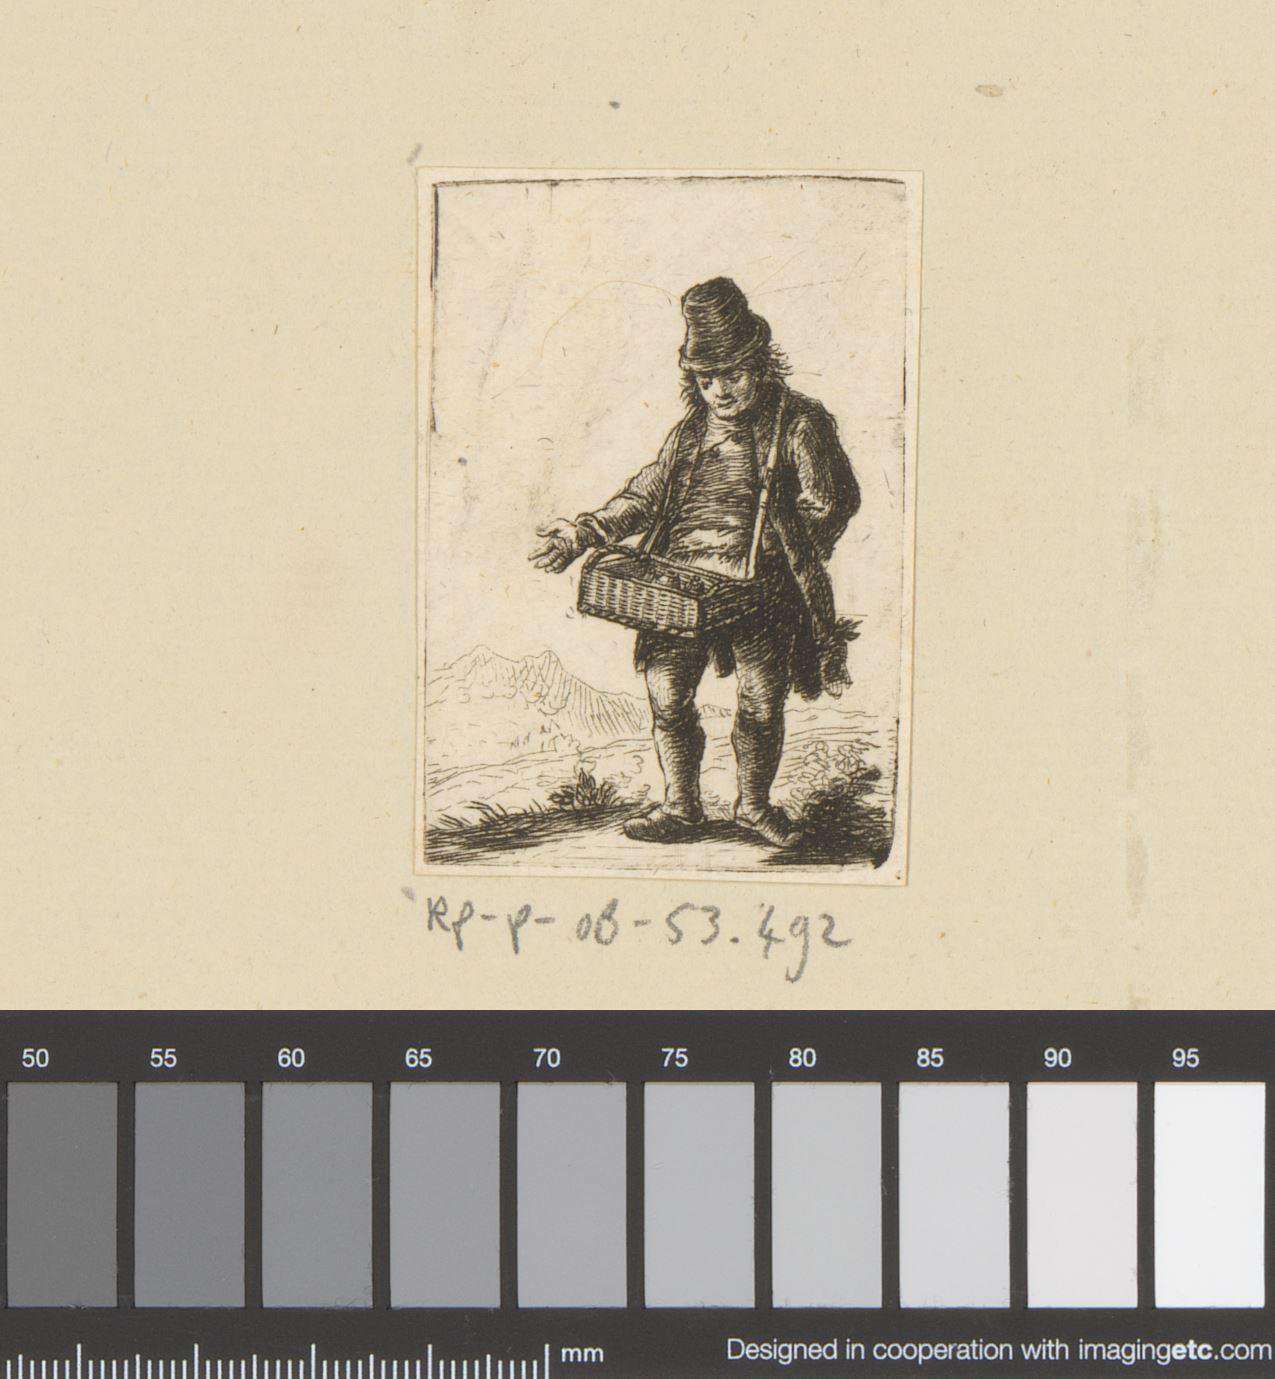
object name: print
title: Marskramer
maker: johann andreas benjamin nothnagel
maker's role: print maker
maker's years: 1729-1804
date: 1739-1804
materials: paper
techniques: etching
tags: wandering or travelling merchant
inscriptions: collector's mark: Lugt 240